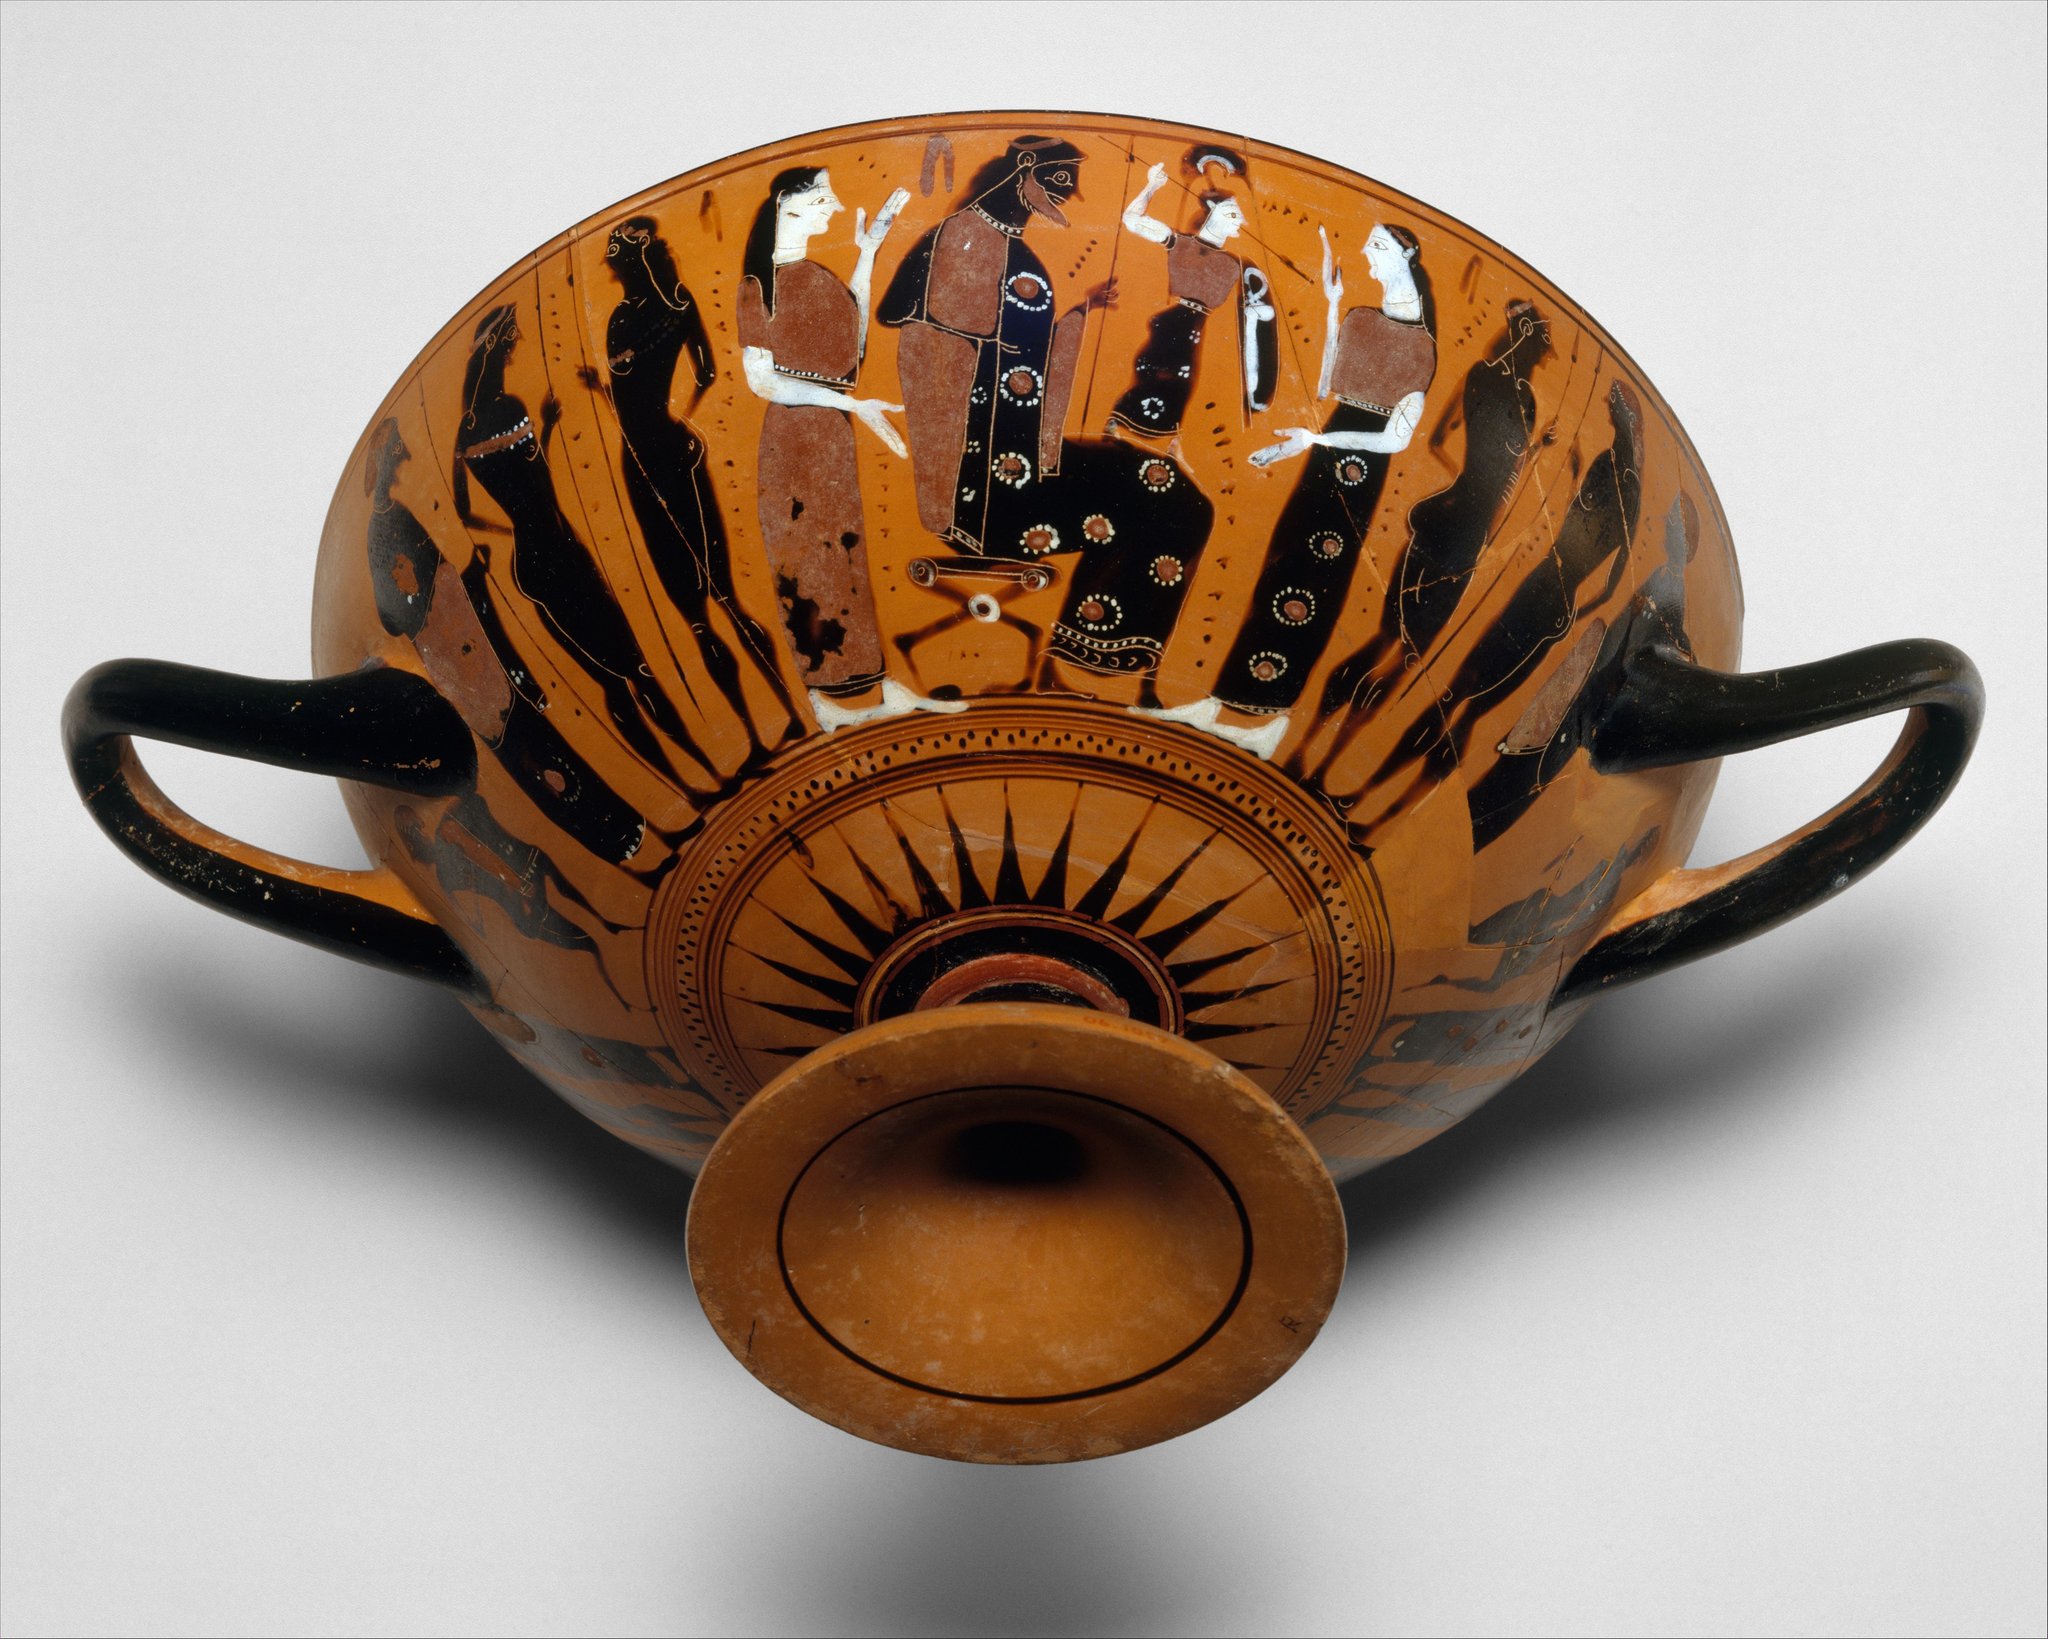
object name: kylix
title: Terracotta kylix (drinking cup)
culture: greek, attic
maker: painter of the nicosia olpe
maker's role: artist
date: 550 BCE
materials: terracotta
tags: athena,zeus